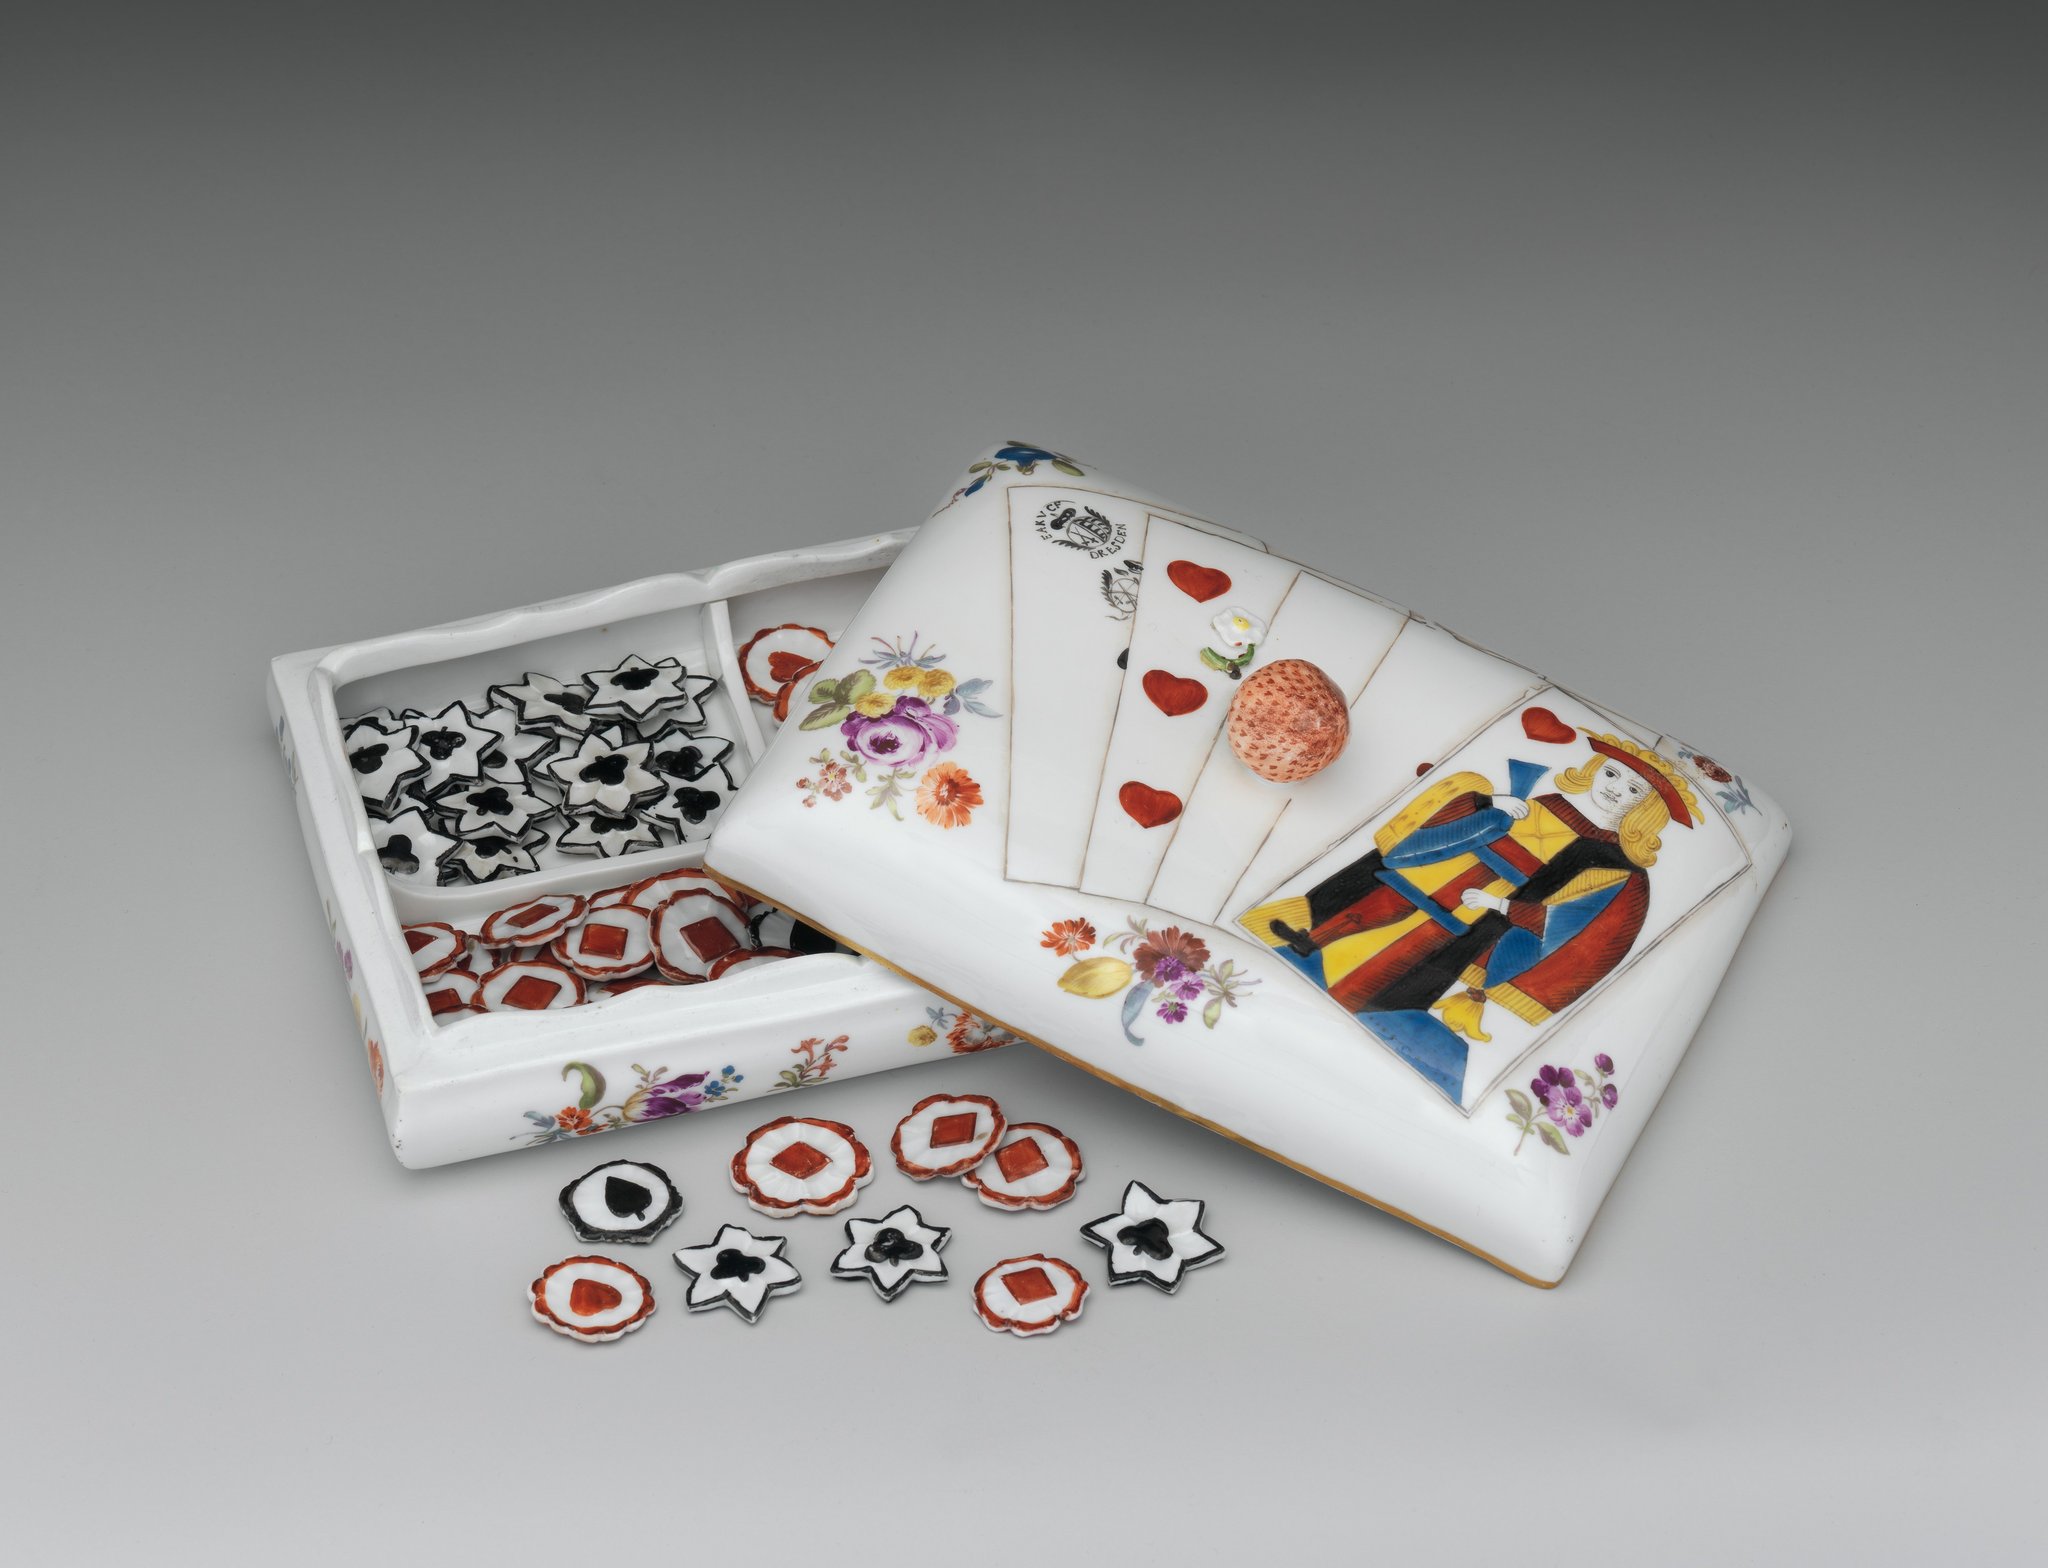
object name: box with cover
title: Box with eighty-one game counters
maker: meissen manufactory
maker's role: manufactory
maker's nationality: german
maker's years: 1710-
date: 1760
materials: hard paste porcelain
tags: playing cards,games